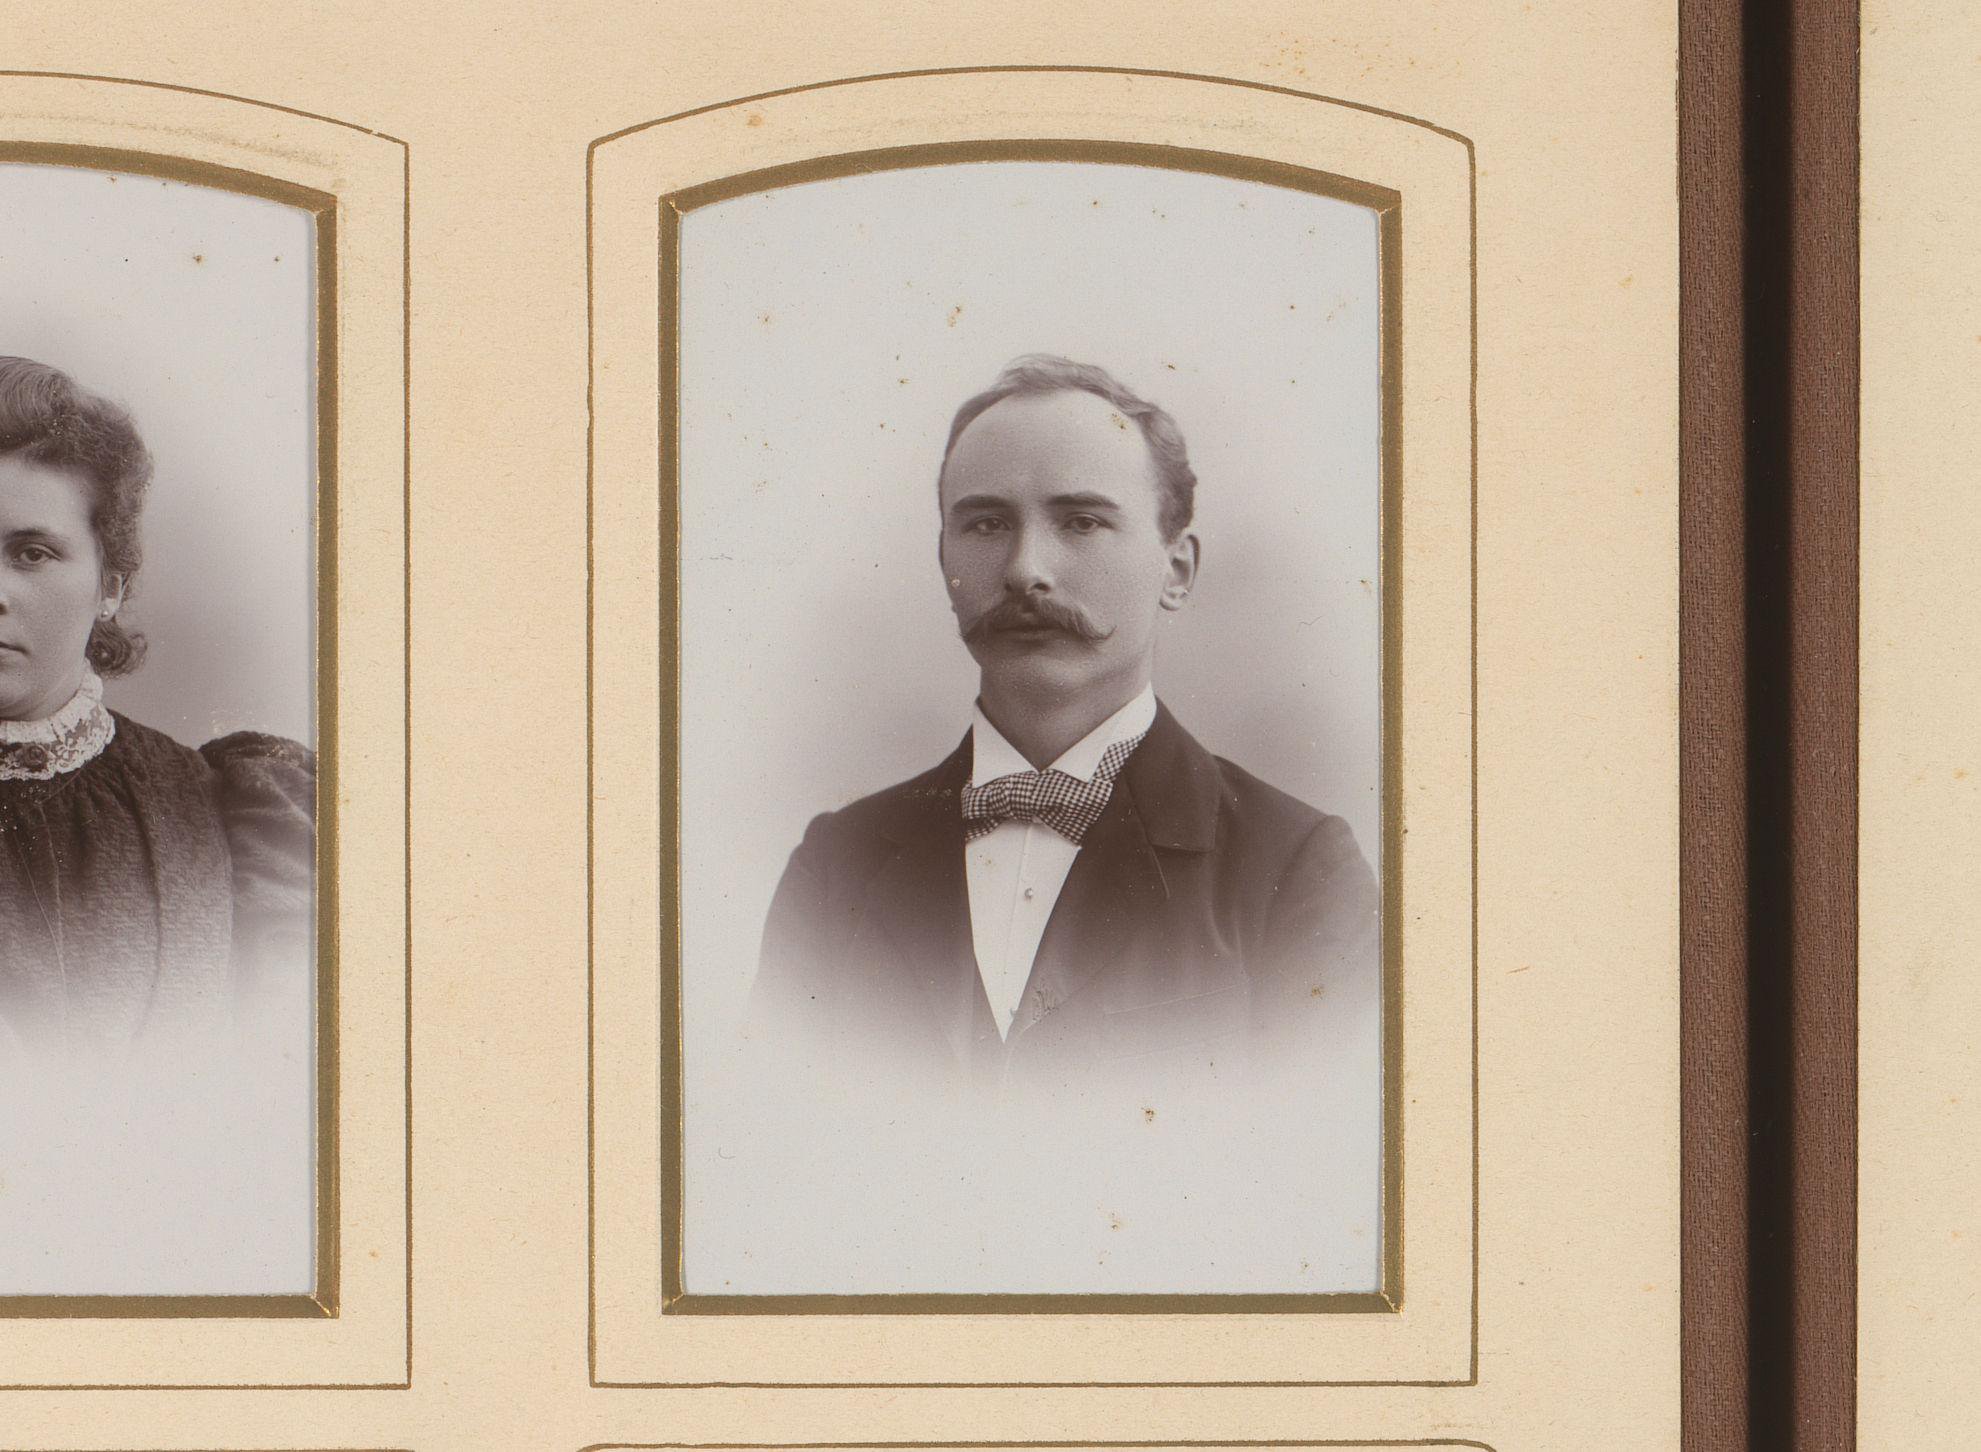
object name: album leaf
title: Portret van een jonge man met snor, aangeduid als Heukman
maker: machiel hendricus laddé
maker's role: fotograaf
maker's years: 1866-1932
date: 1892-1906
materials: cardboard, photographic support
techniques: collodion silver print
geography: amsterdam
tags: moustache, historical persons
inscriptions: inscription: ‘No. 23278/ Photographie/ Artistique/ M. H. Laddé/ boven de Firma/ MERKELBACH & Co./ Amsterdam/ Nieuwendijk 57-59./ Het Cliche wordt voor verdere bestellingen bewaard’, name: ‘Heukman’